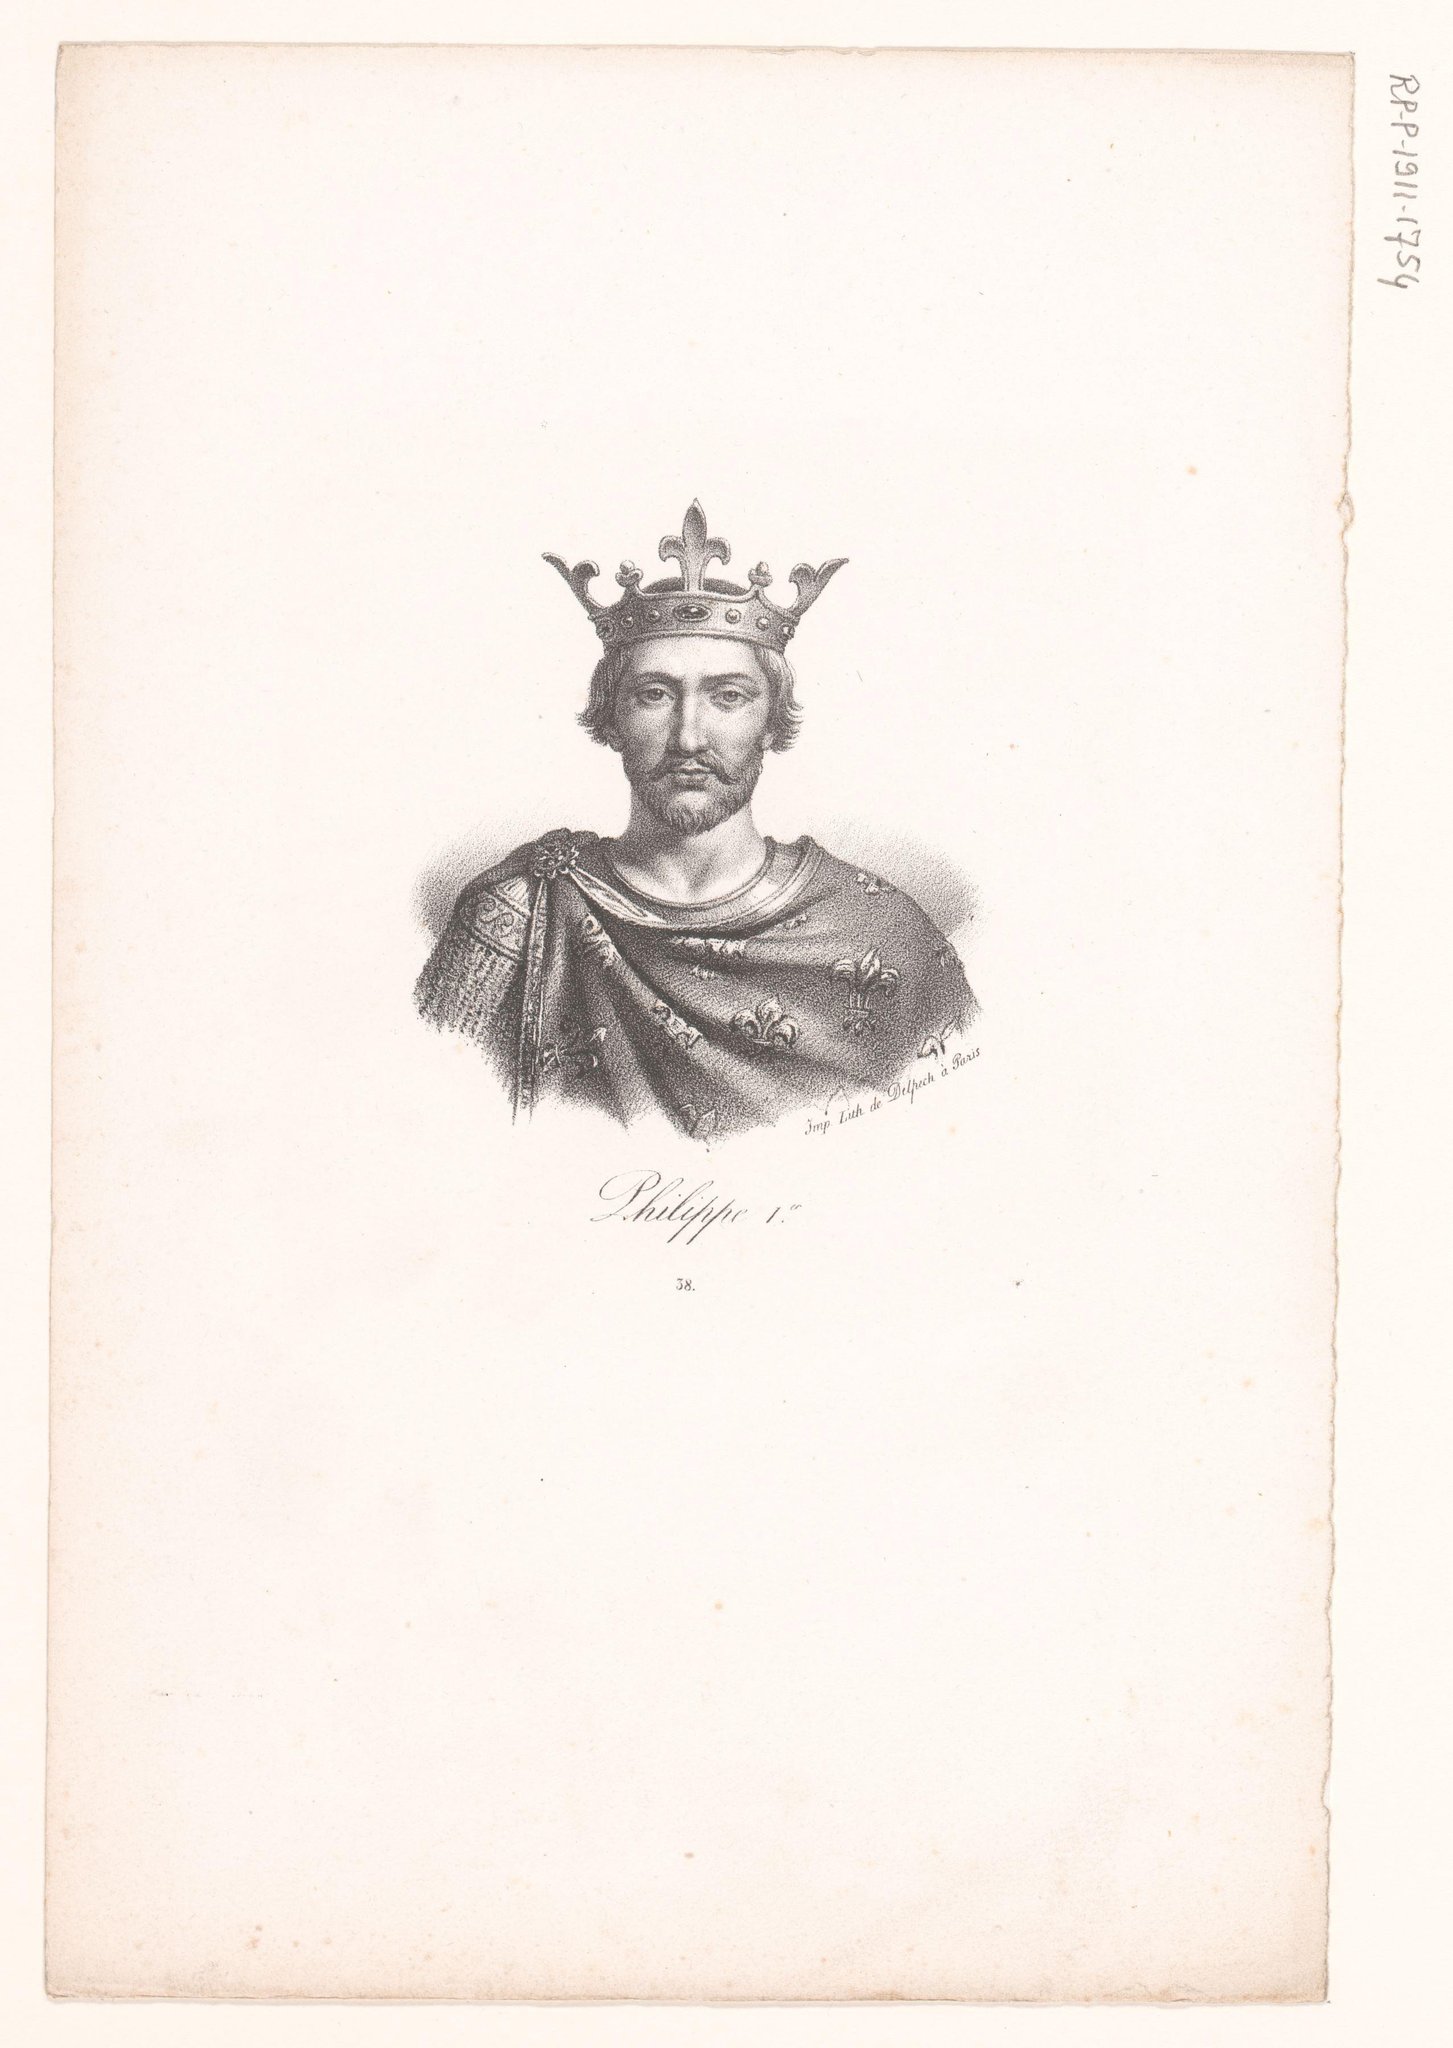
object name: print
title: Philippe 1er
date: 1818-1842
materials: paper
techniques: lithograph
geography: paris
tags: historical persons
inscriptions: collector's mark: Lugt 2228a